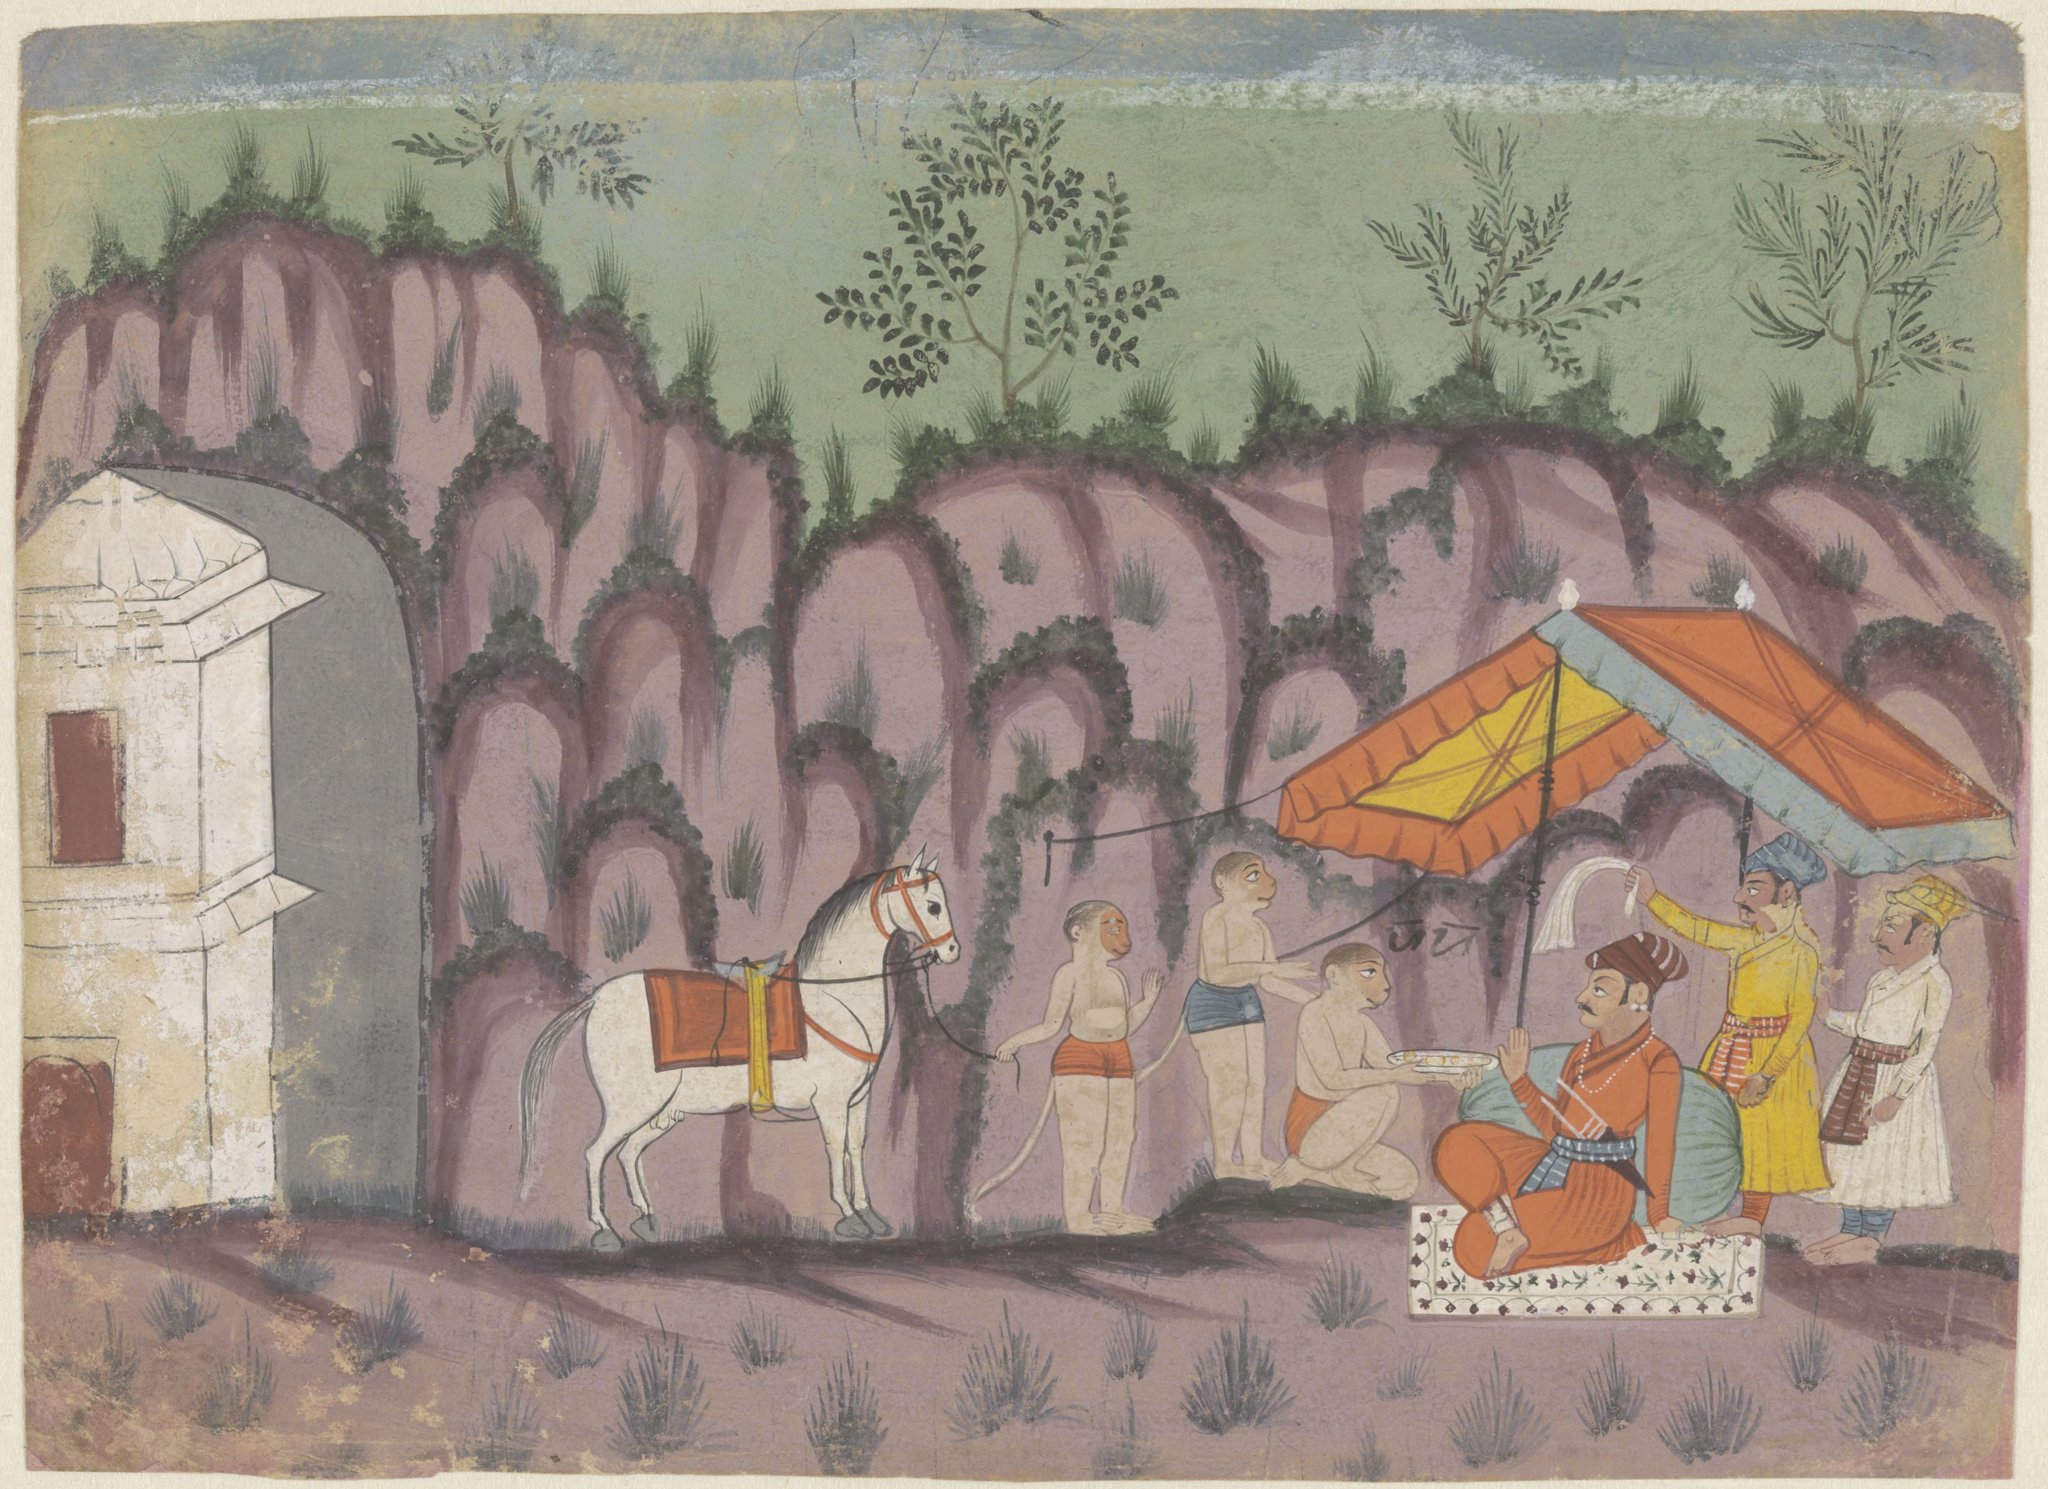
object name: indian miniature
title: Vorst met wit paard onder een tentdak in een rotsachtig landschap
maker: Anonymous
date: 1690-1710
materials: paper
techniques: brush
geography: bilaspur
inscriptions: inscription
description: In een rotsachtig landschap zit onder een tentdak een vorst op een wit kleedje, achter hem twee dienaars, waarvan een een witte doek over hem heen houdt, voor hem drie aapmensen met een wit paard aan de leidsels die hem een schaal met lekkernijen aanbieden.